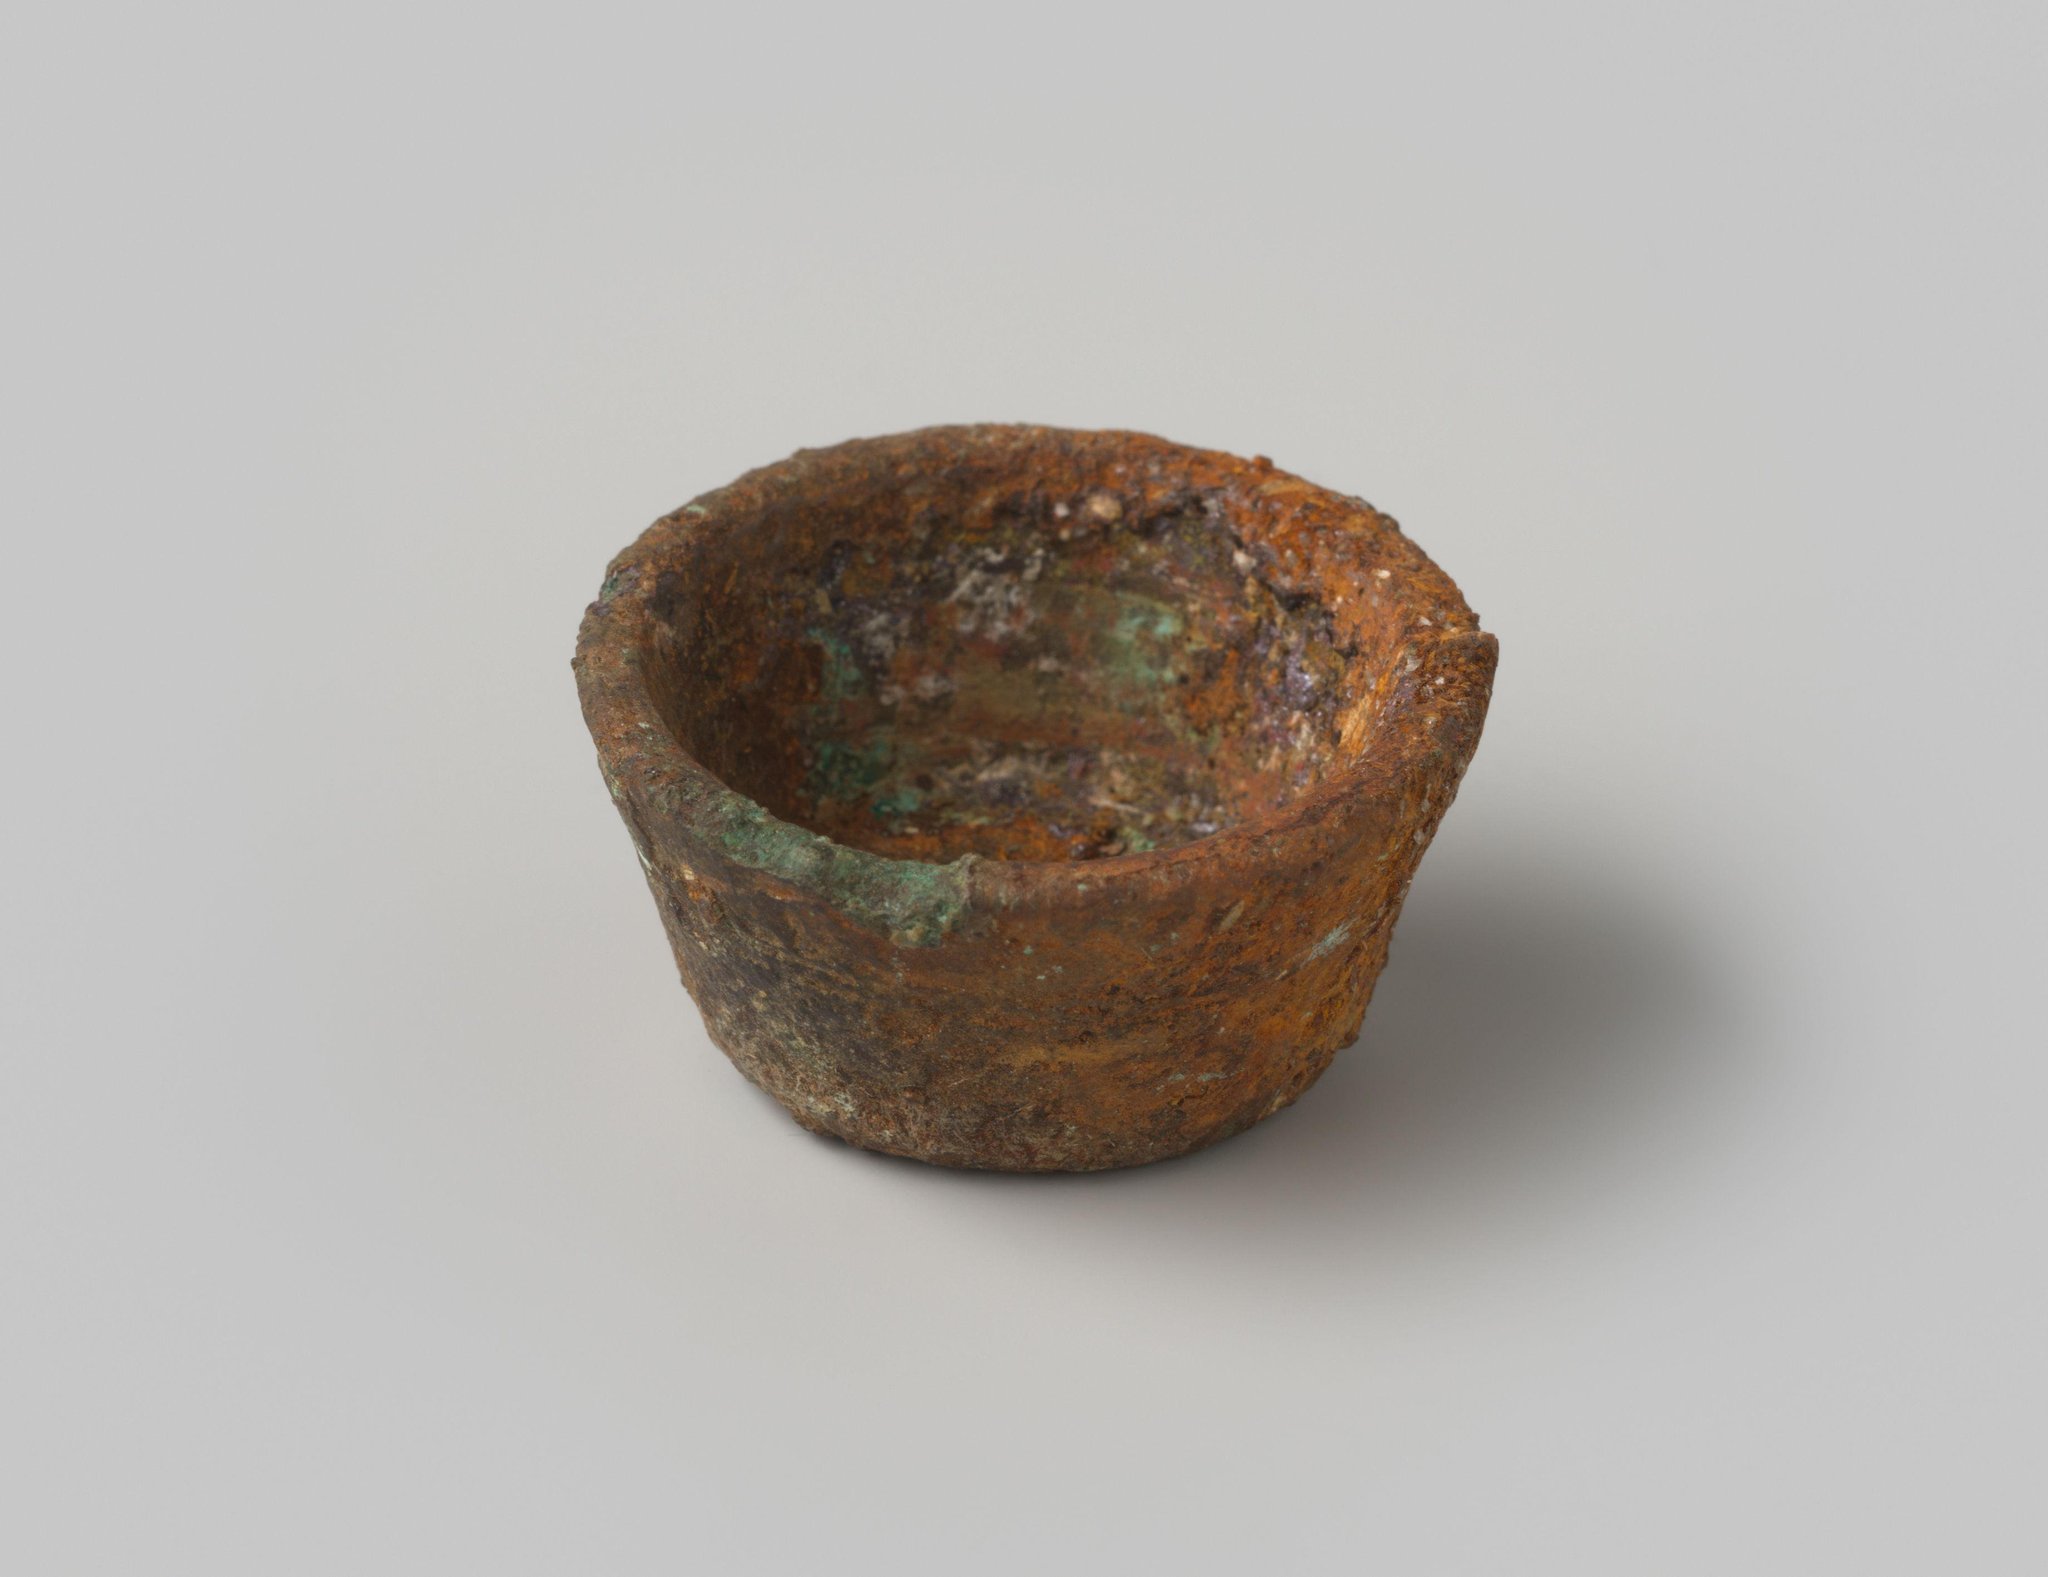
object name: weight scale component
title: Gewicht van sluitgewicht uit het wrak van de Oost-Indiëvaarder Hollandia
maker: Anonymous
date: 1700-1743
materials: copper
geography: netherlands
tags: verenigde oostindische compagnie, hollandia (schip), annet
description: Weight, cupweight, cup; id. NG 1980-27H2775, corroded, no marks legible.